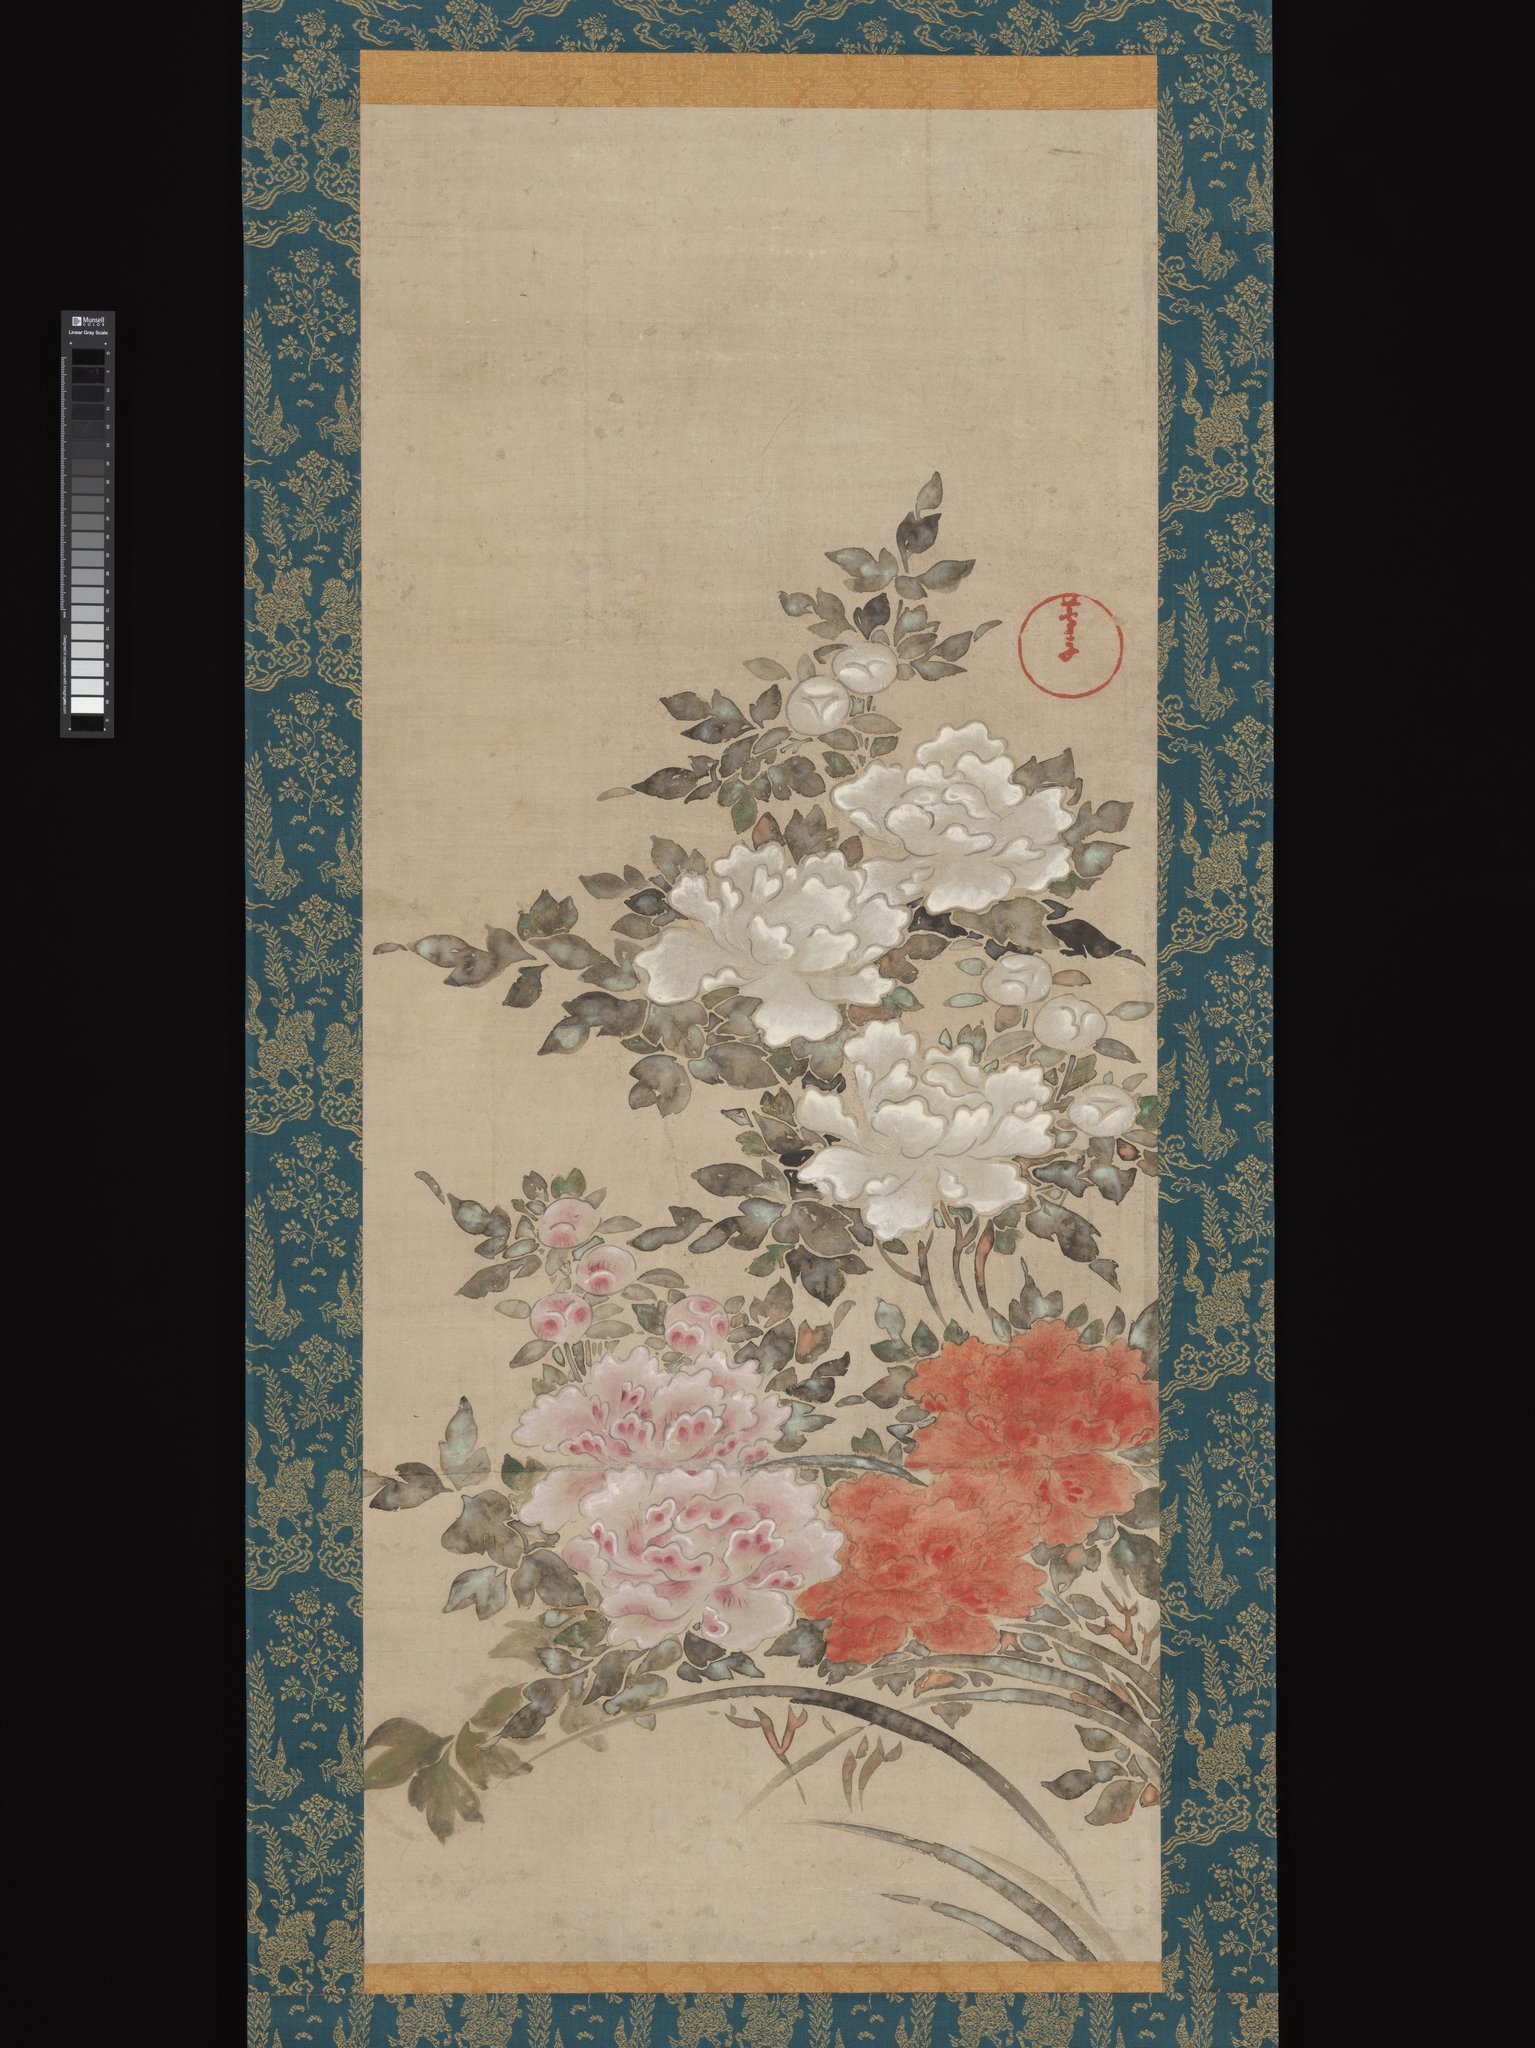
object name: hanging scroll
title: Peonies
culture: japanese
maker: fukae roshū 深江蘆舟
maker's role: artist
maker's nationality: japanese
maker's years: 1699-1757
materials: gold, ink, panel, paper